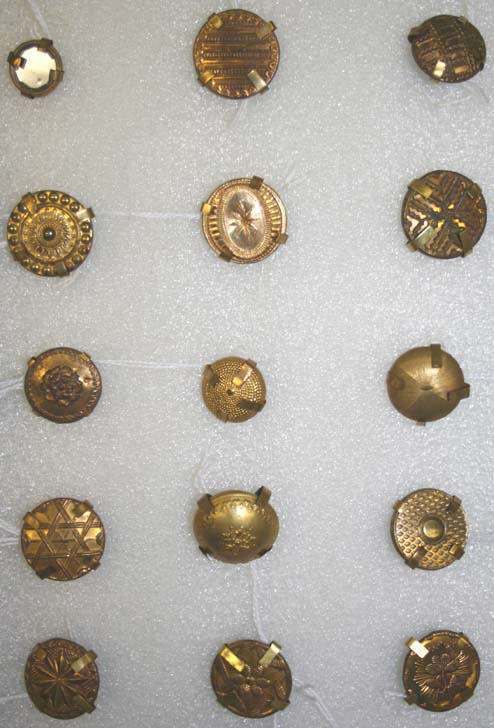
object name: button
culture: french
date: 1780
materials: bone, wood